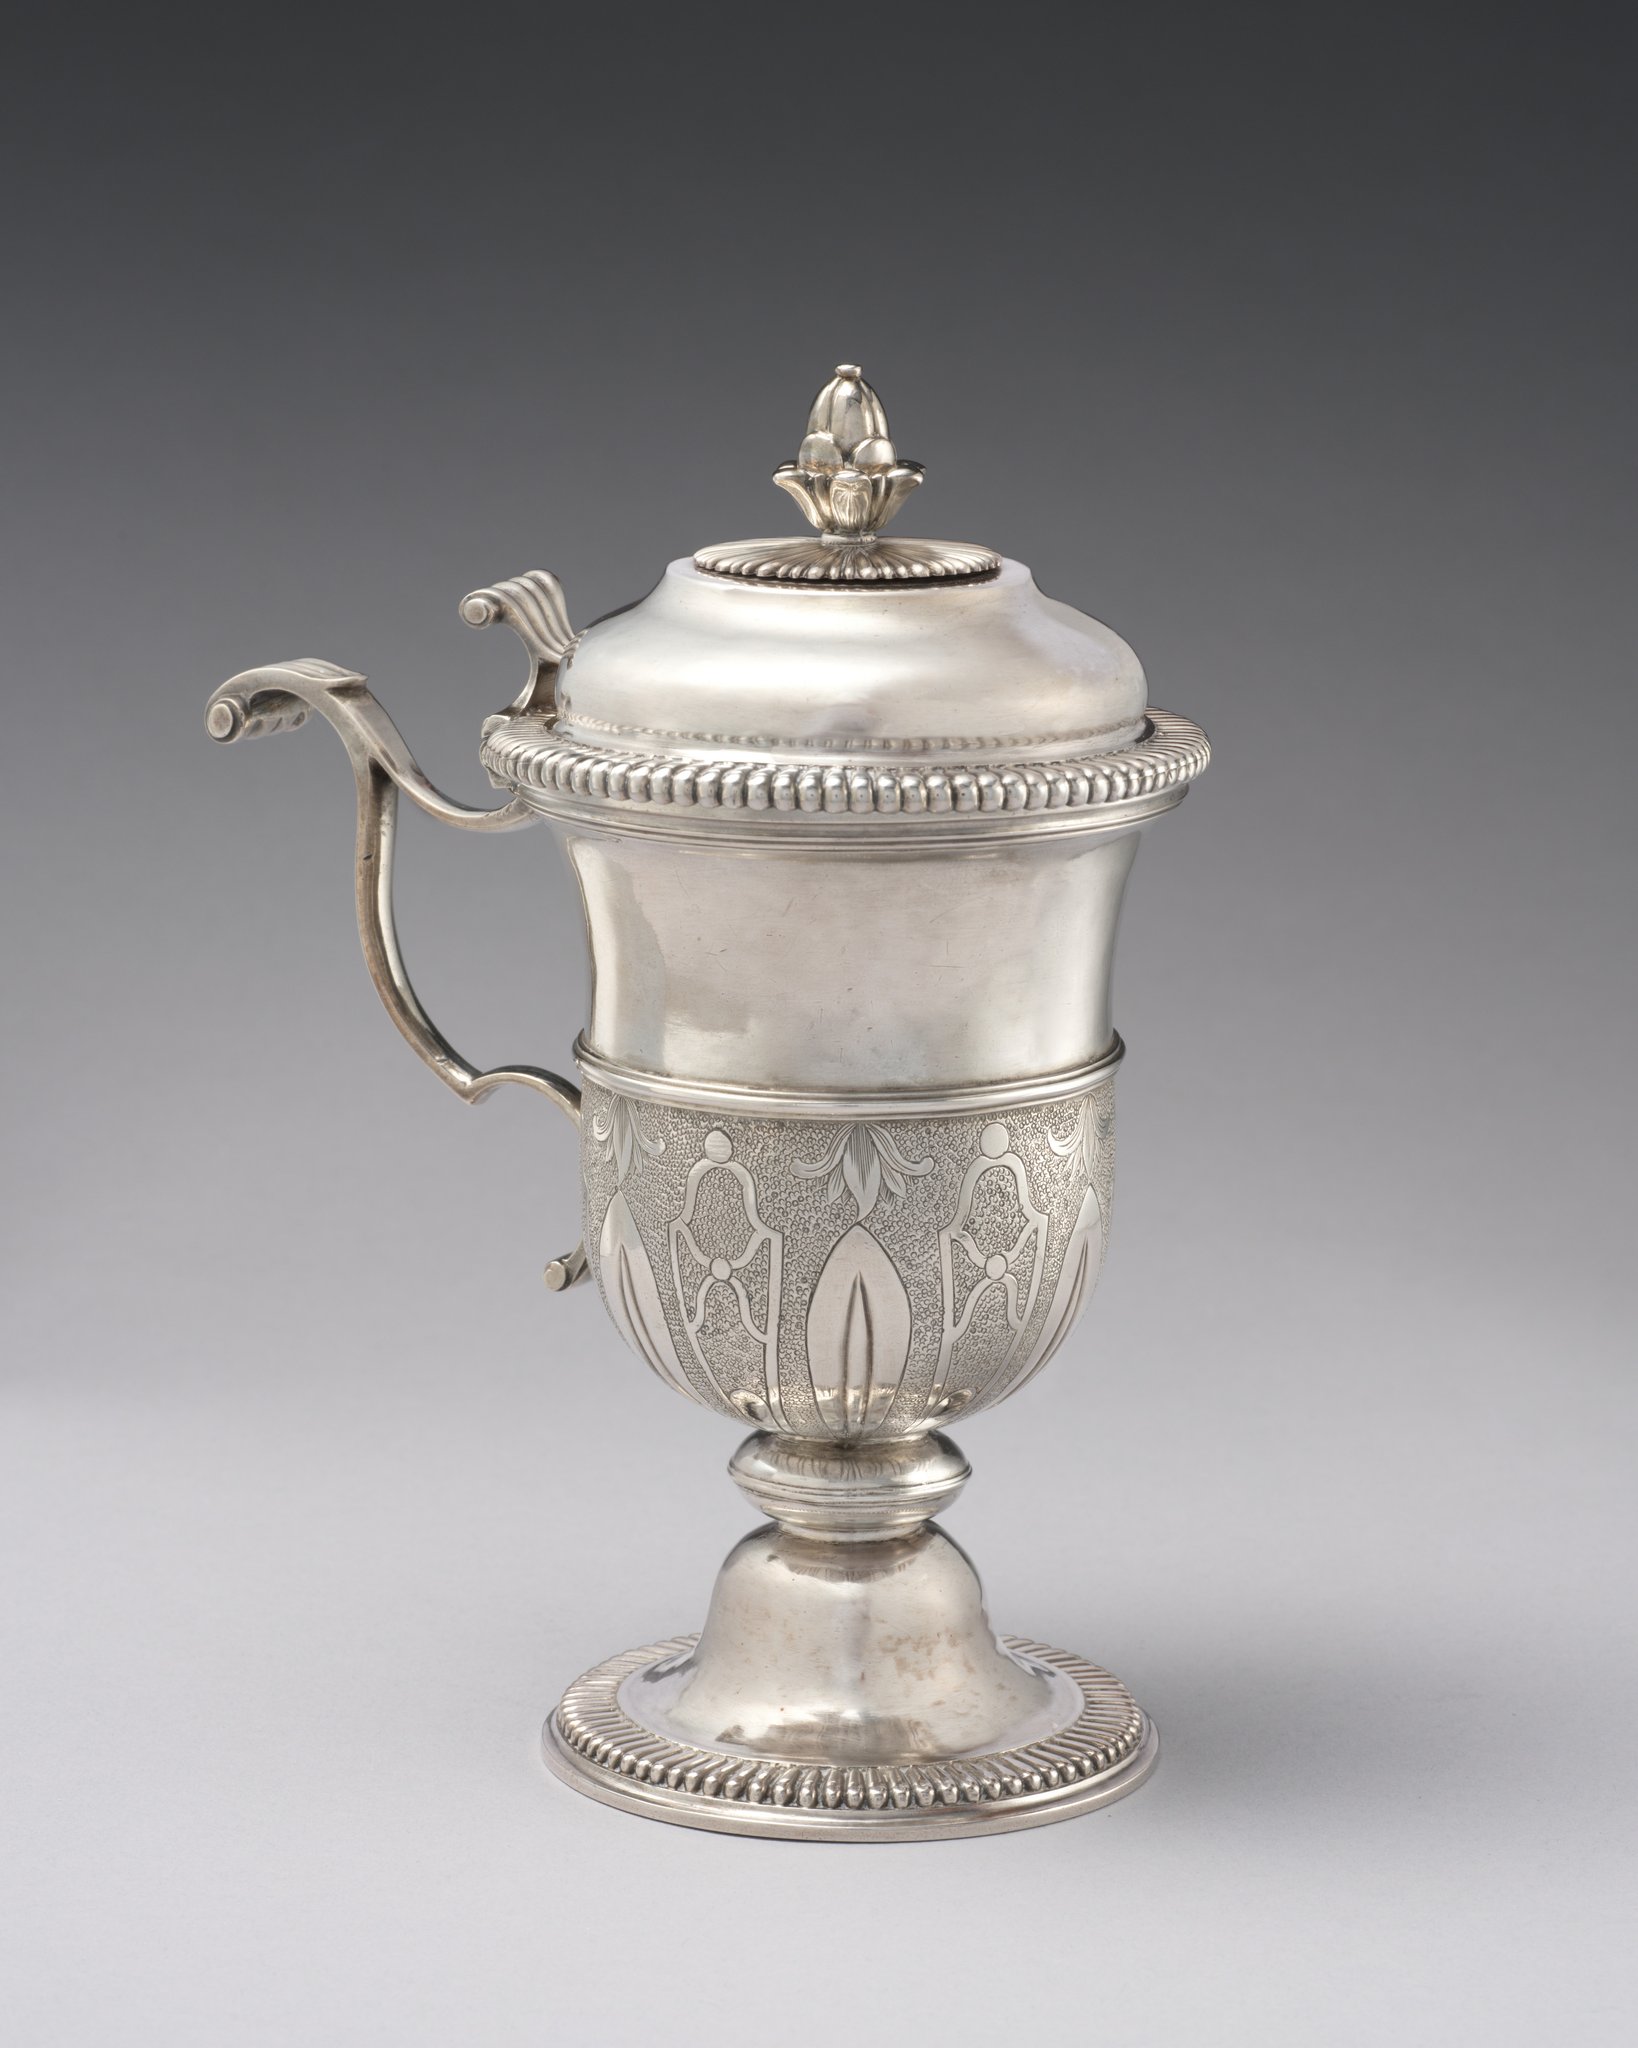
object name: mustard pot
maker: pierre-louis du floo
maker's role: maker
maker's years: 1695-1767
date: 1753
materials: silver